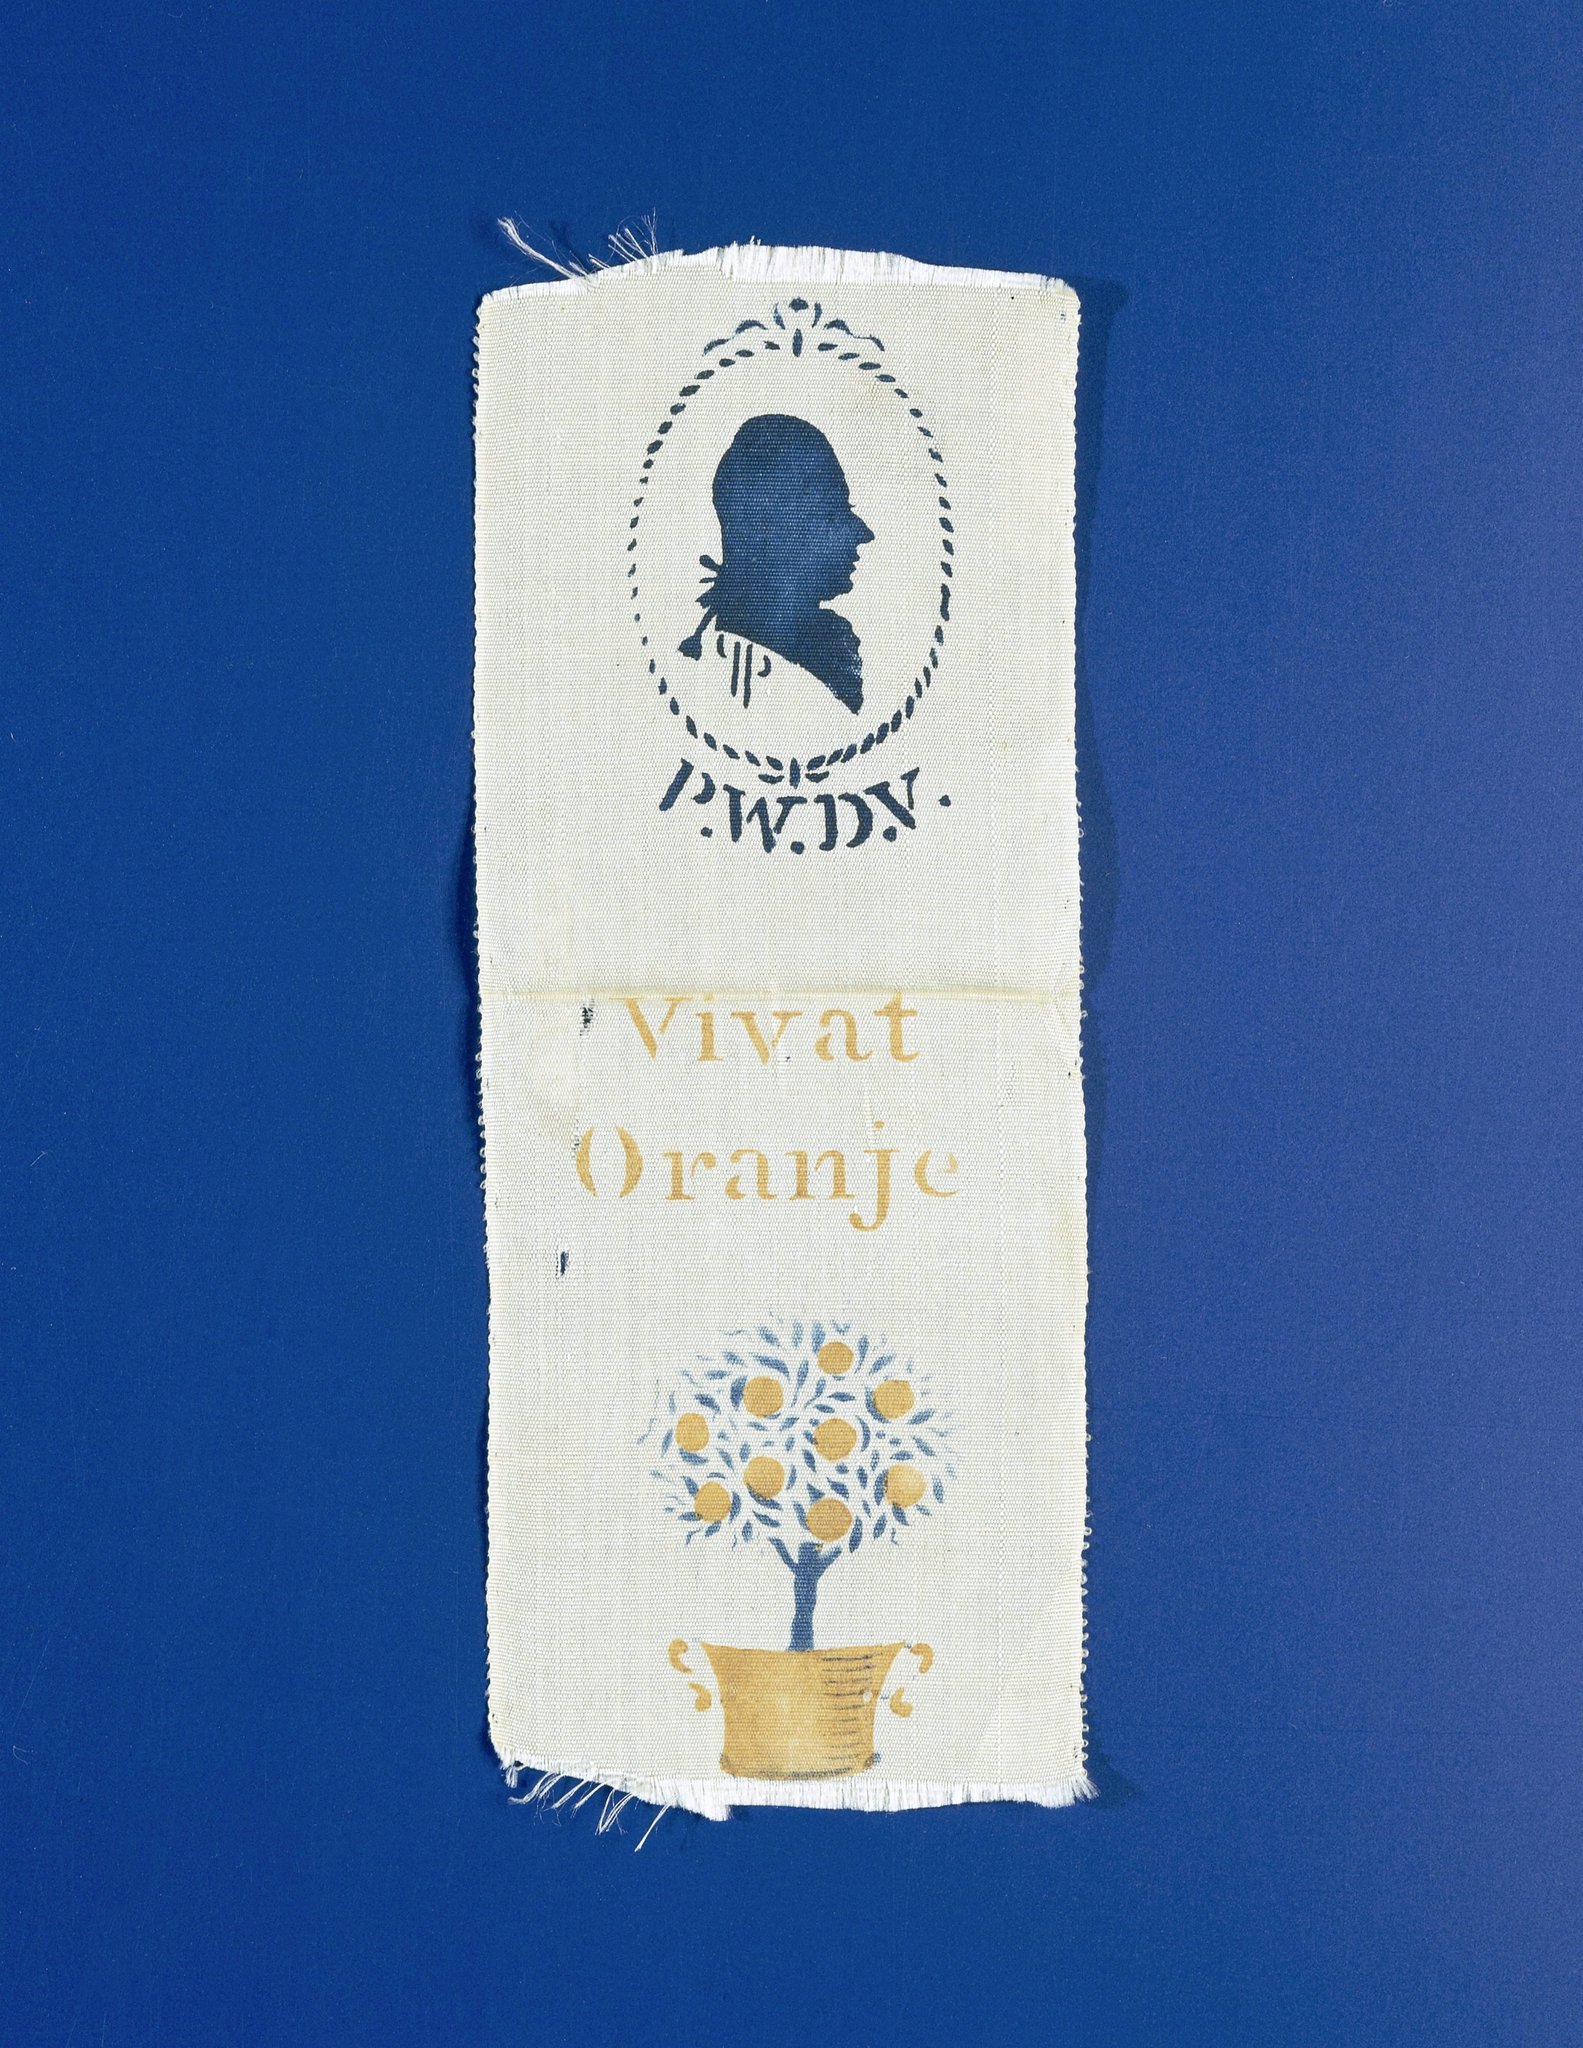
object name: ribbon material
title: Oranjelint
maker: Anonymous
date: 1775-1800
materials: silk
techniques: printing, weave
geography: netherlands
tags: the hague, william v (prince of orange)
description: Orange ribbon with inscriptions and illustrations.